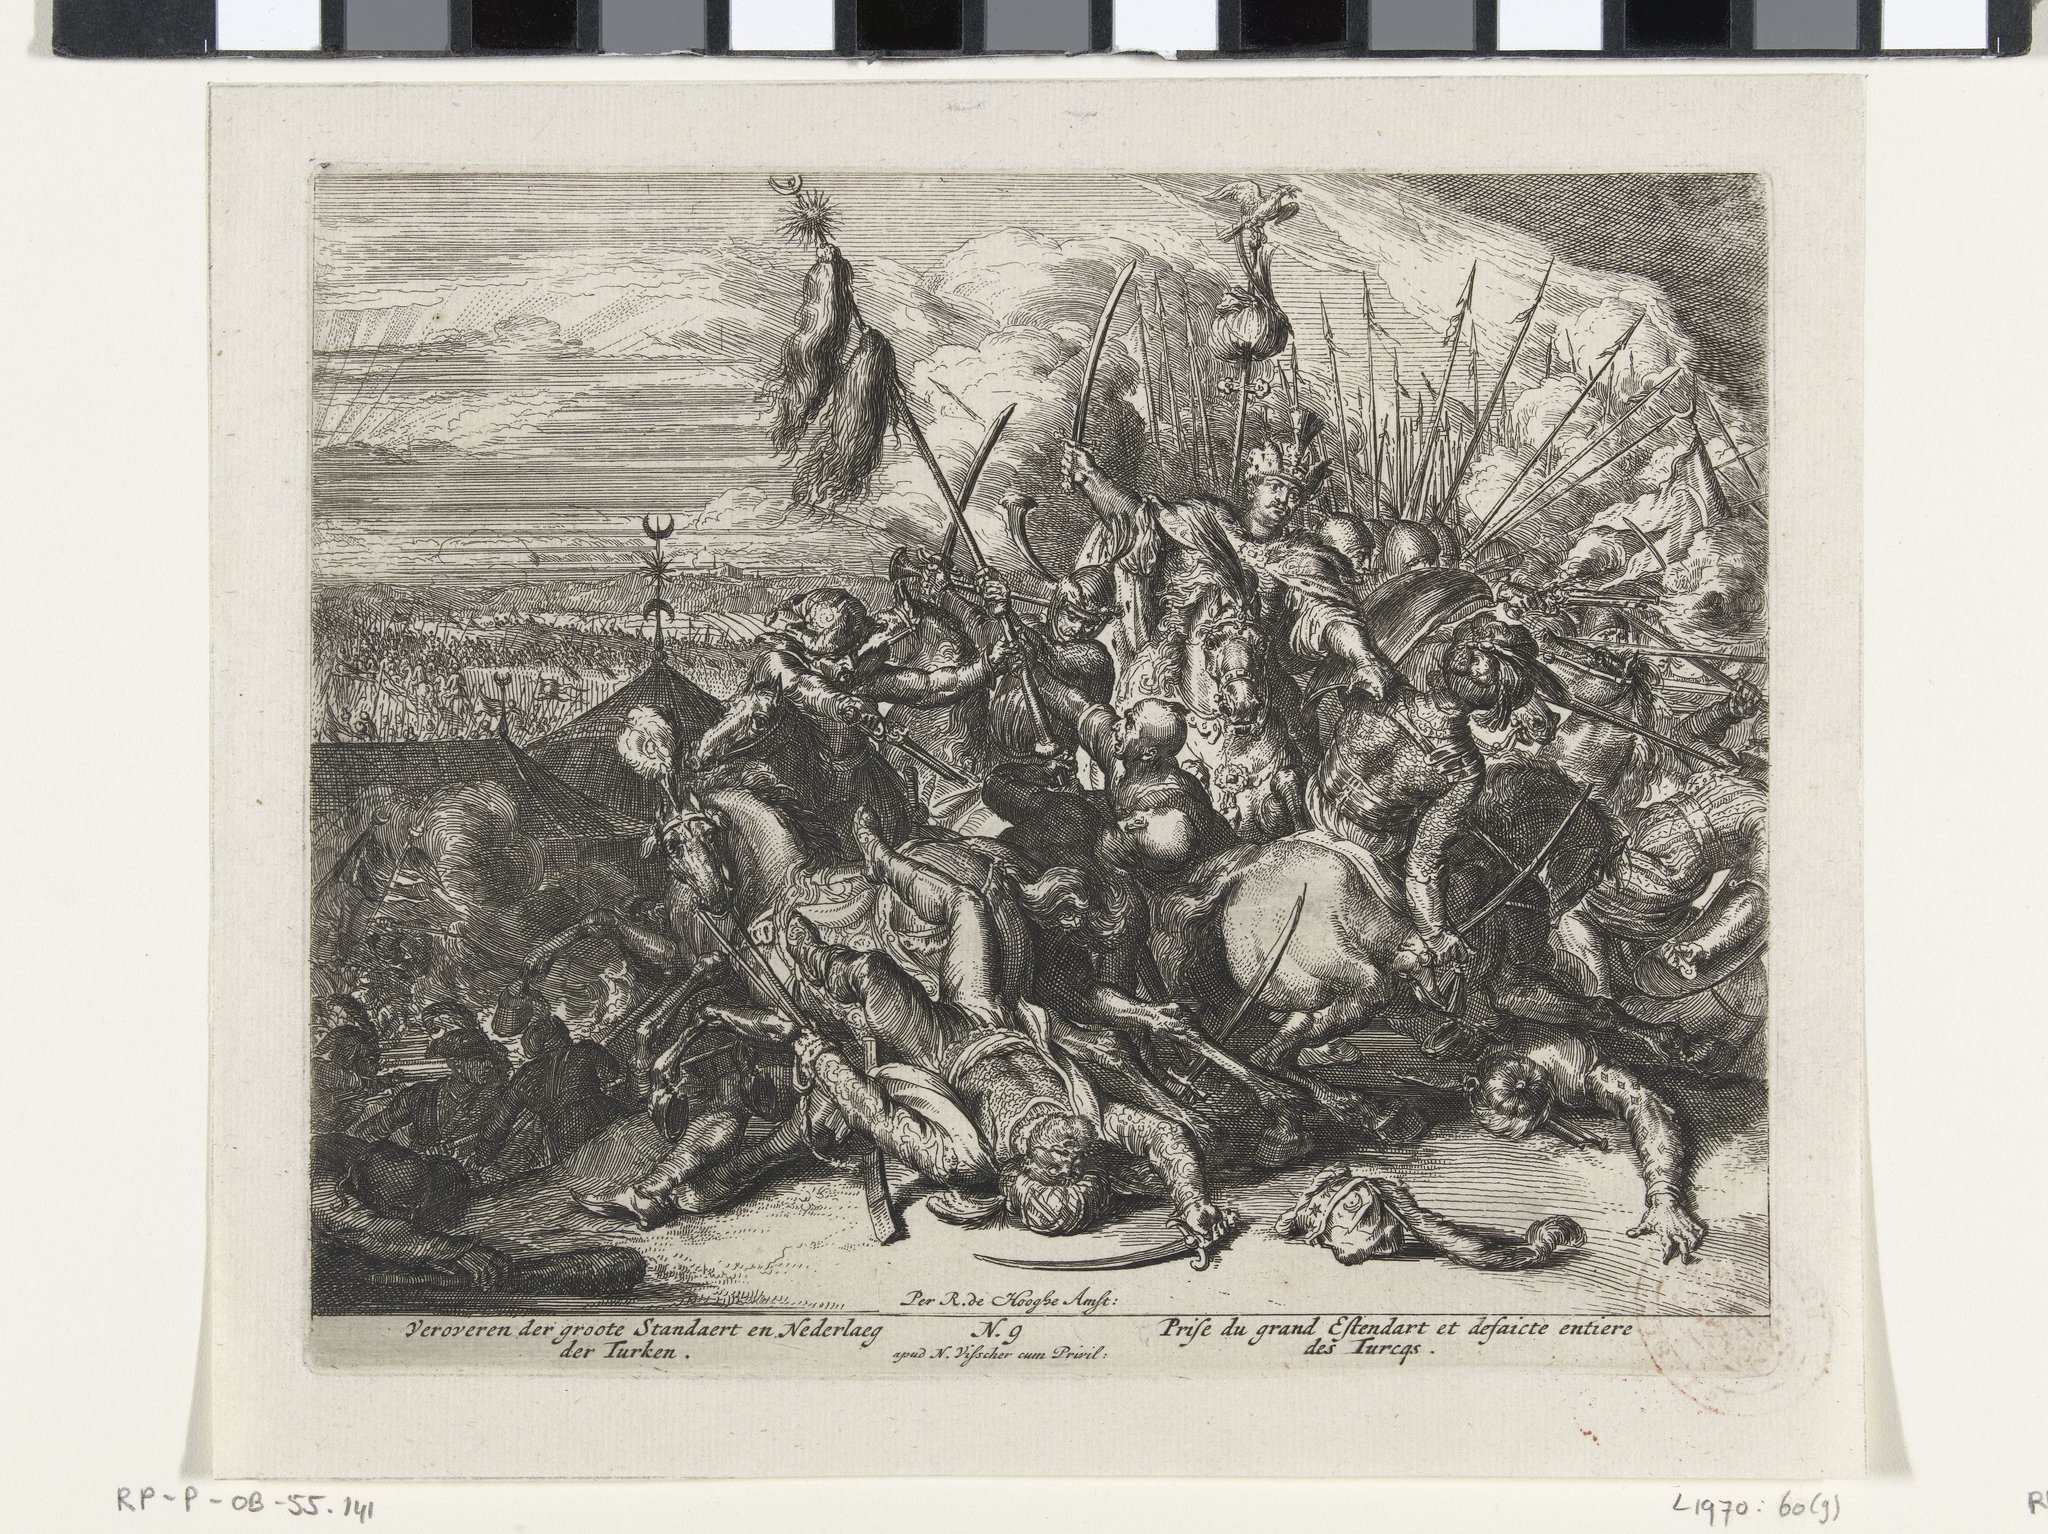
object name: print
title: Veroveren der groote Standaert en Nederlaeg der Turken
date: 1684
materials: paper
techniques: engraving, etching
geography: amsterdam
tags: jan iii sobieski (koning van polen), vienna, leopold i (keizer van duitsland), battle, fighting in general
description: Illustratie voor Johann van Ghelen, Relation succinte et veritable de tout ce qui s'est passé pendant le siege de Vienne, residence de Sa Majesté Imperiale, assiegée par les Turcs depuis le 14. juillet jusqu'au 12. de septembre 1683., Bruxelles: Jean Leonard, 1684.